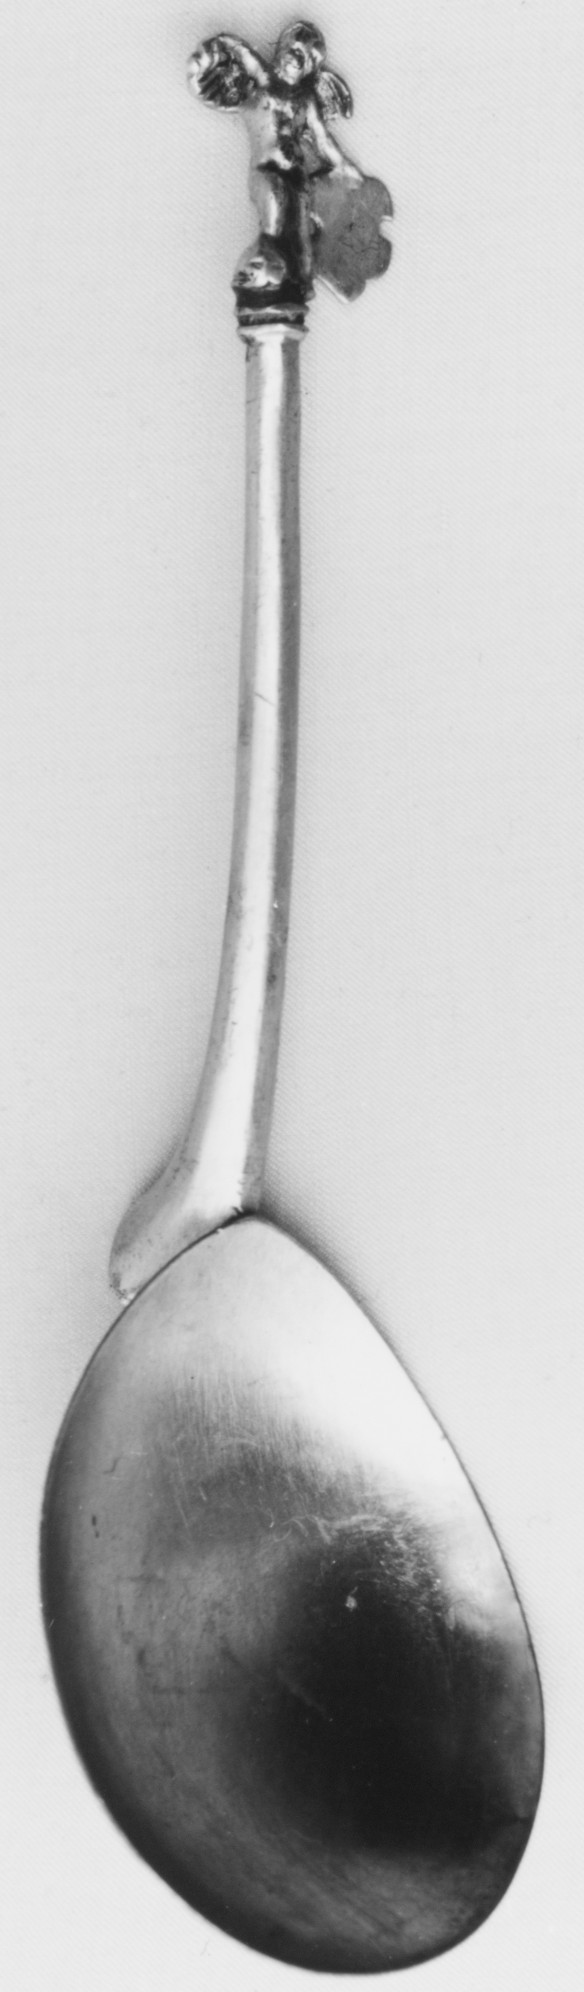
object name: spoon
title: Figure-top spoon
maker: hans bott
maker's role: maker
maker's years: 1627-1659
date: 1626-1650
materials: silver gilt